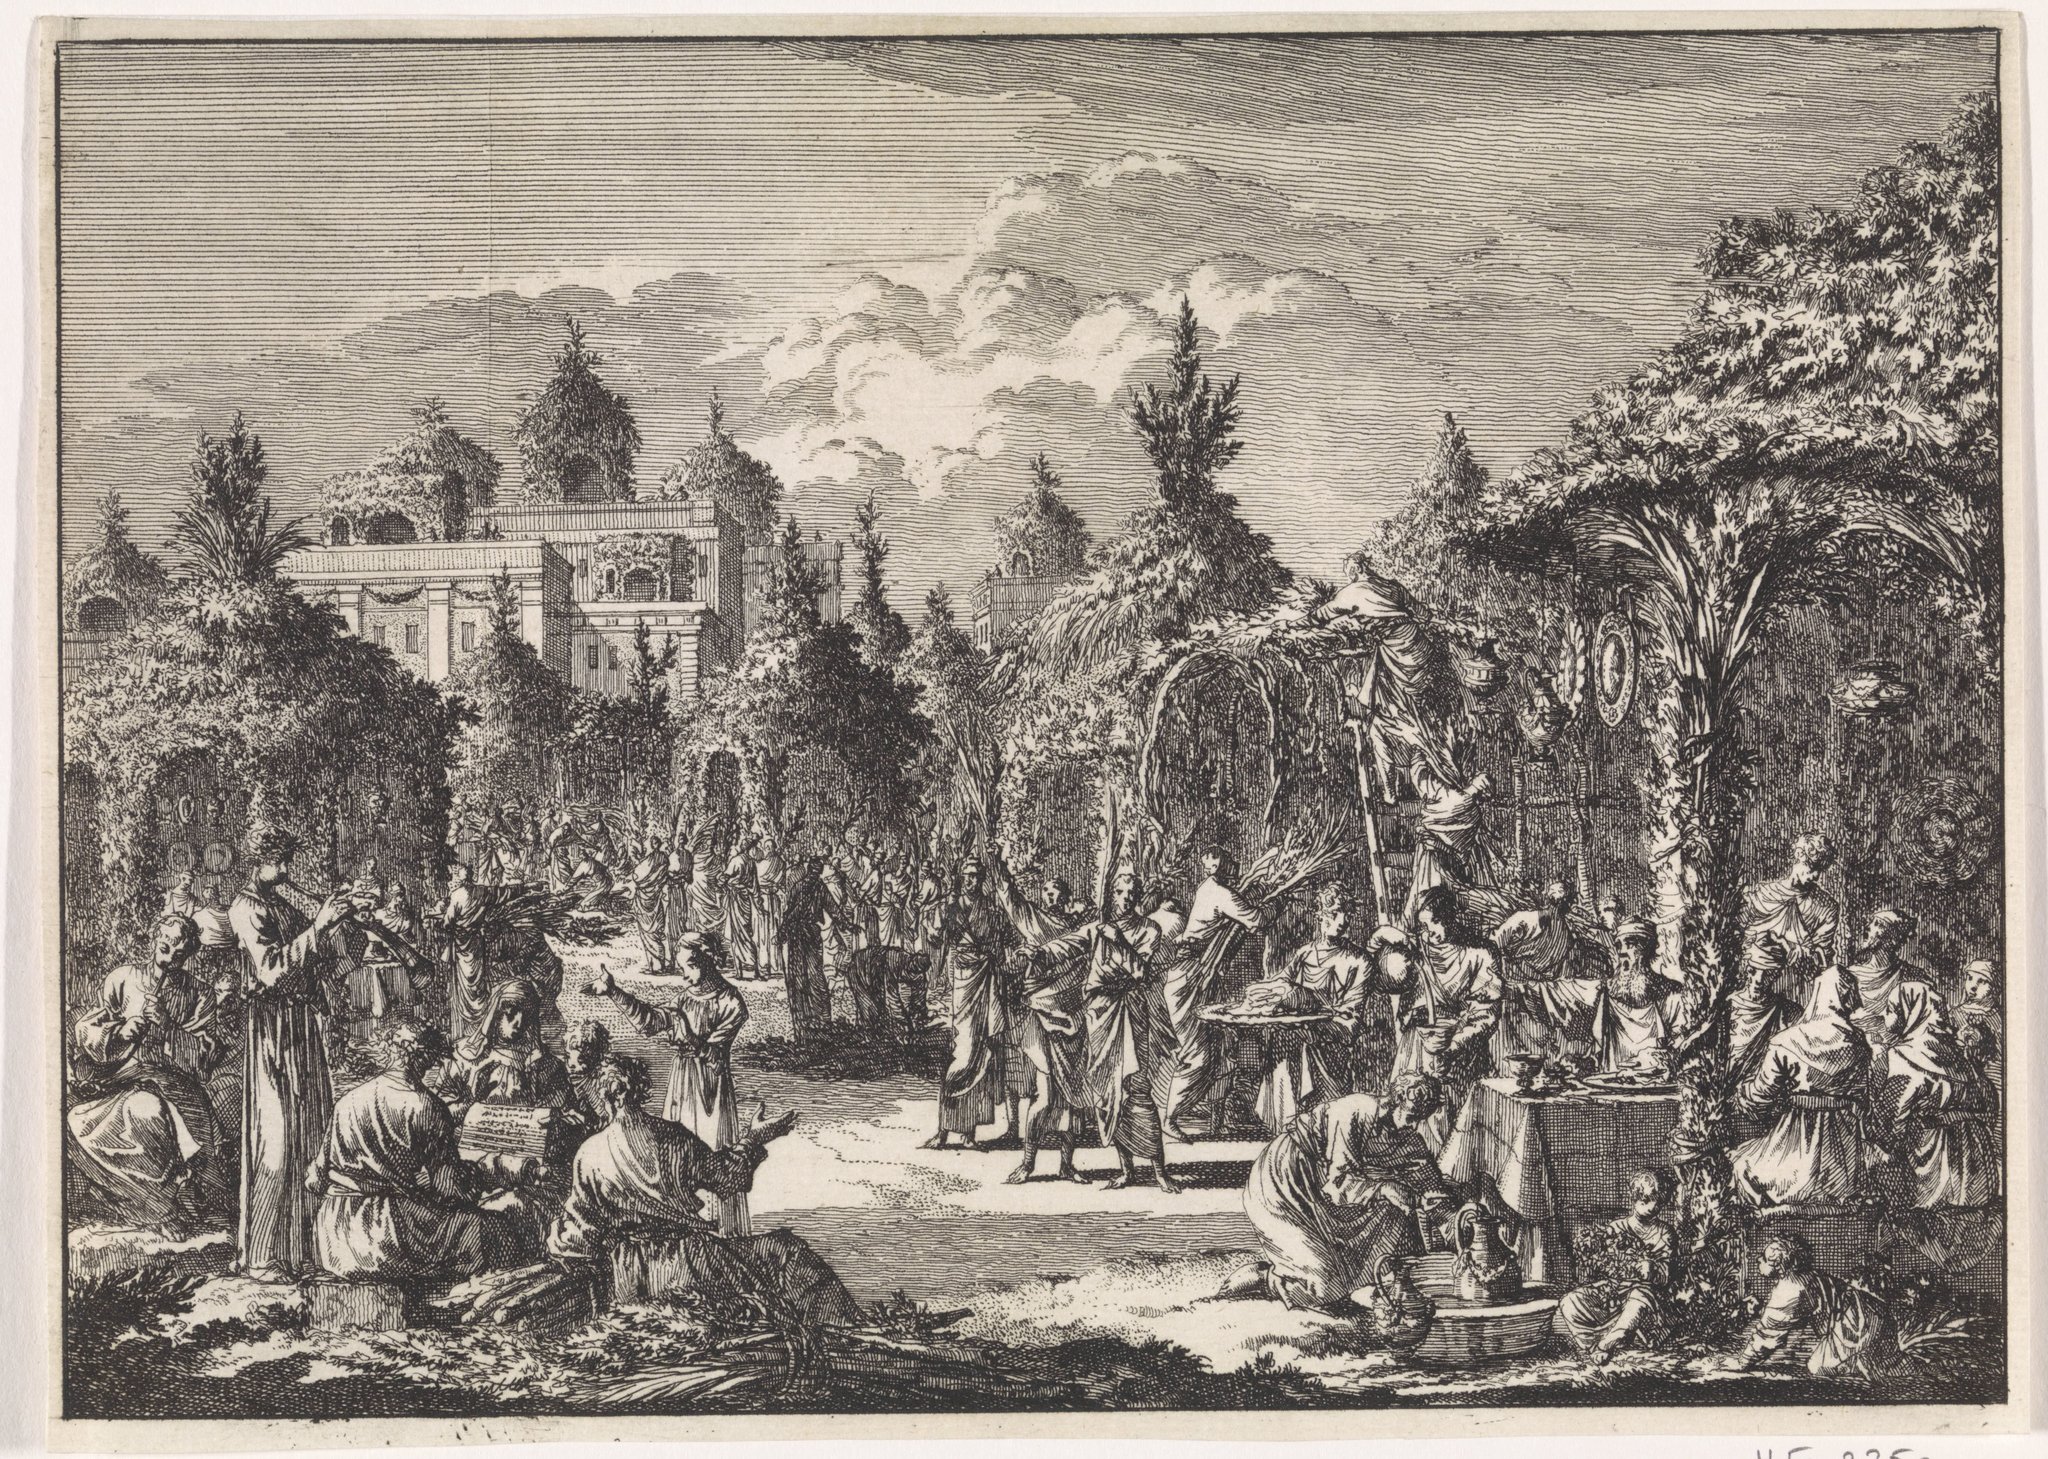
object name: print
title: Loofhuttenfeest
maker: jan luyken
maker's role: draughtsman, print maker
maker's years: 1649-1712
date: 1705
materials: paper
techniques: etching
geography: amsterdam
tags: 'sukkot', feast of the tabernacles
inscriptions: collector's mark: Lugt 2228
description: Proefdruk van illustratie uit: Cunaeus, Petrus. La republique des Hebreux, 3 delen. Amsterdam: Pieter Mortier, 1705, dl. I, p. 288.